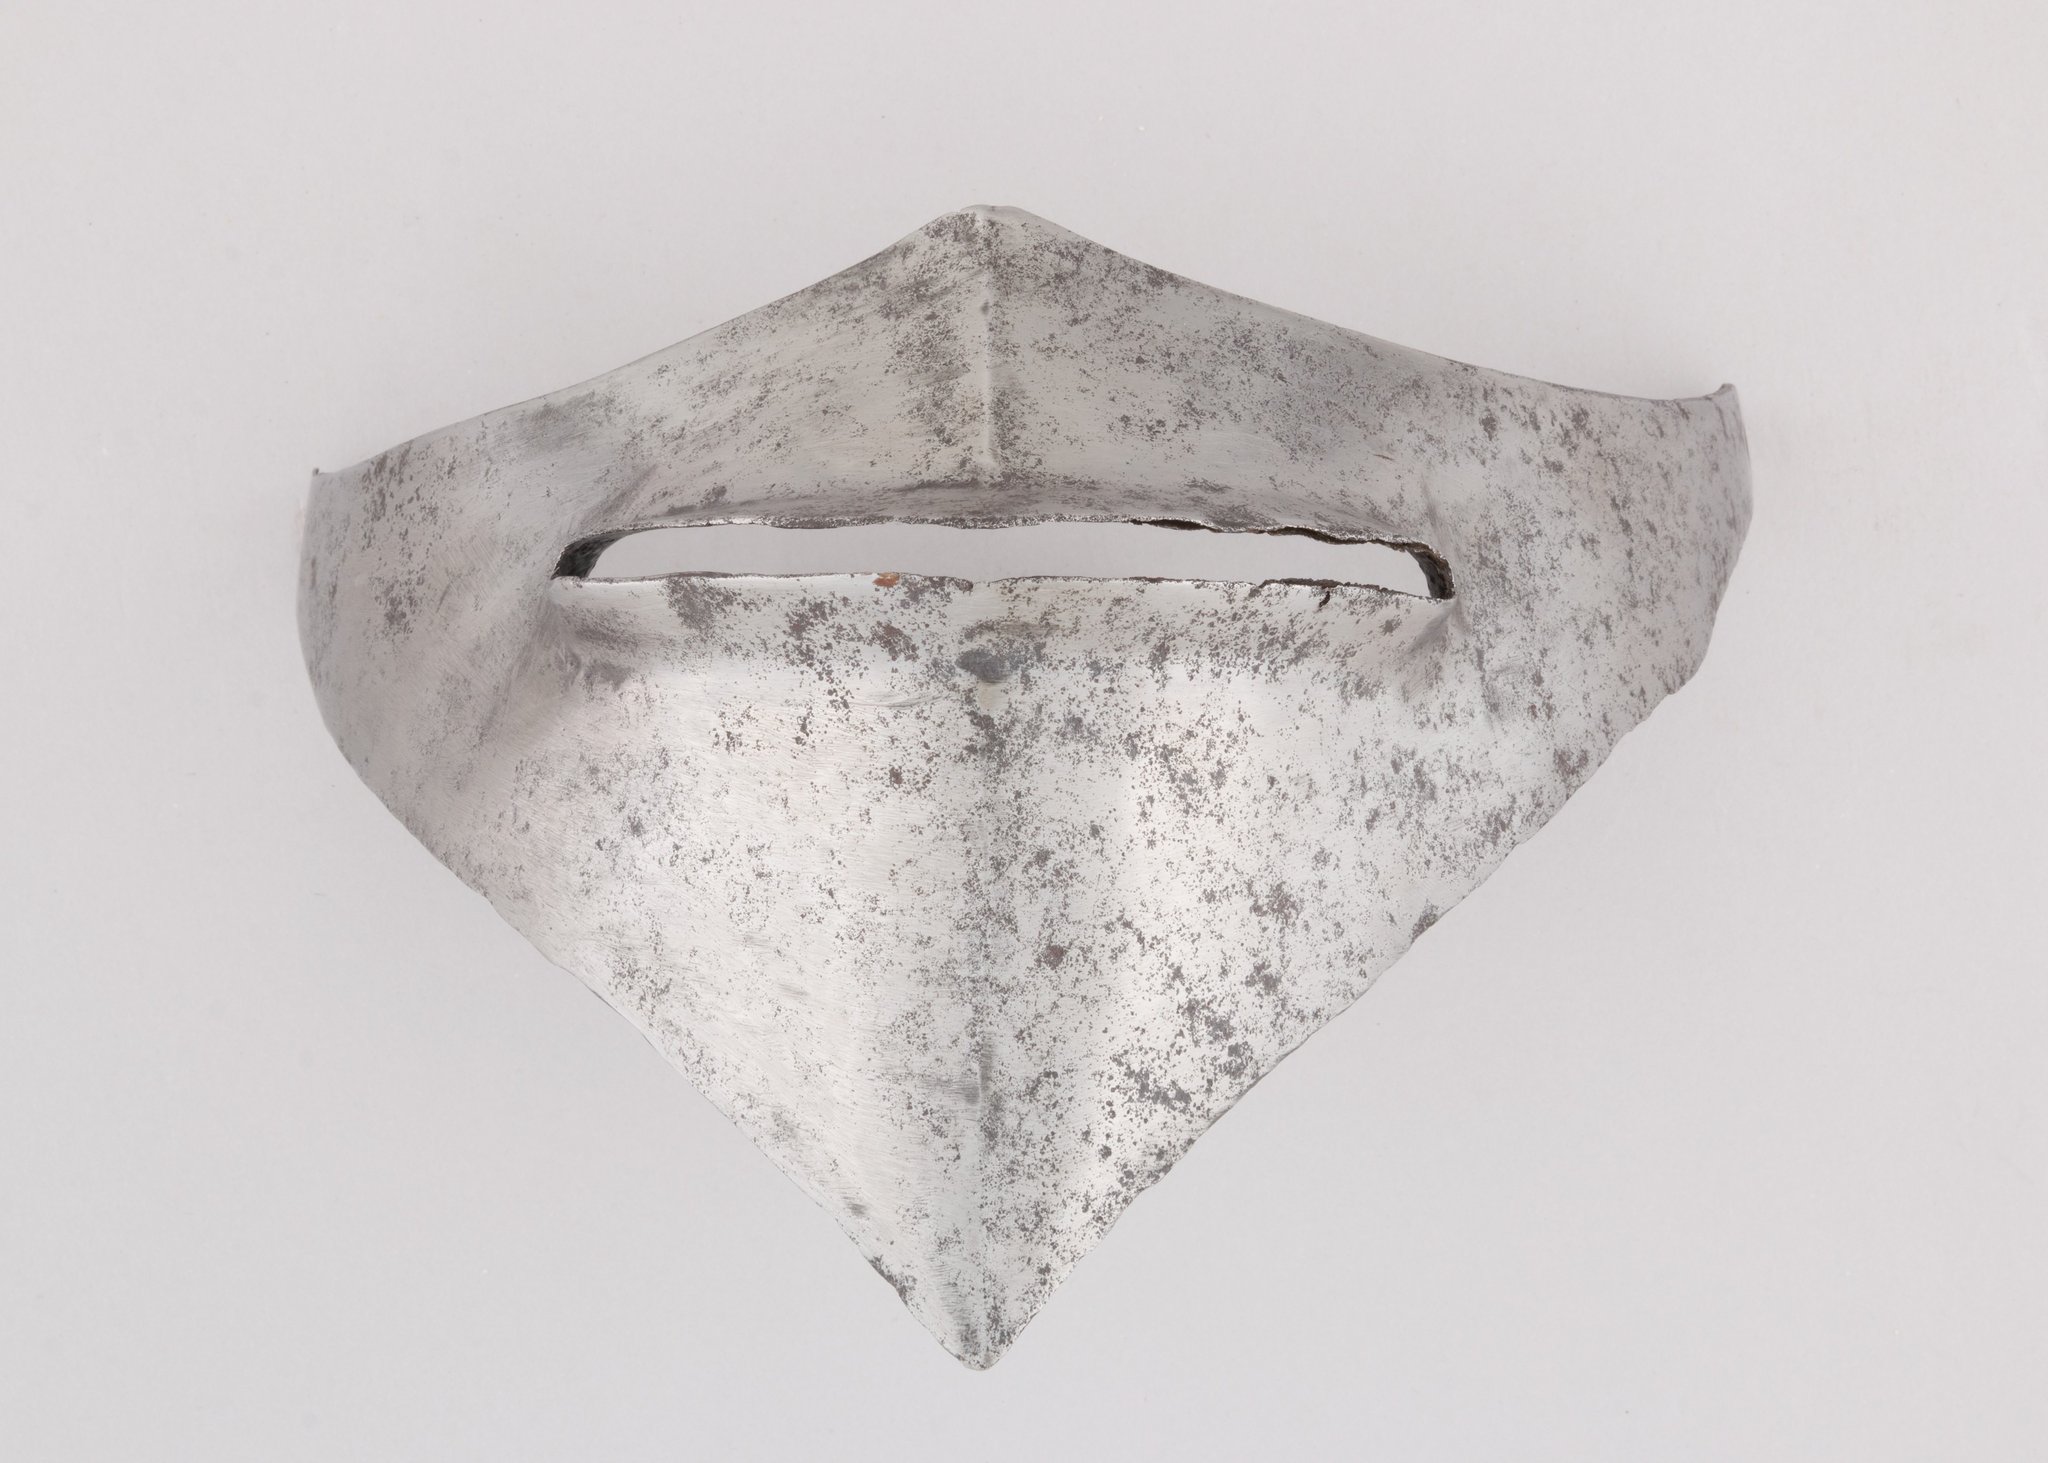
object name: visor for a bascinet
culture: italian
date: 1400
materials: steel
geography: italy